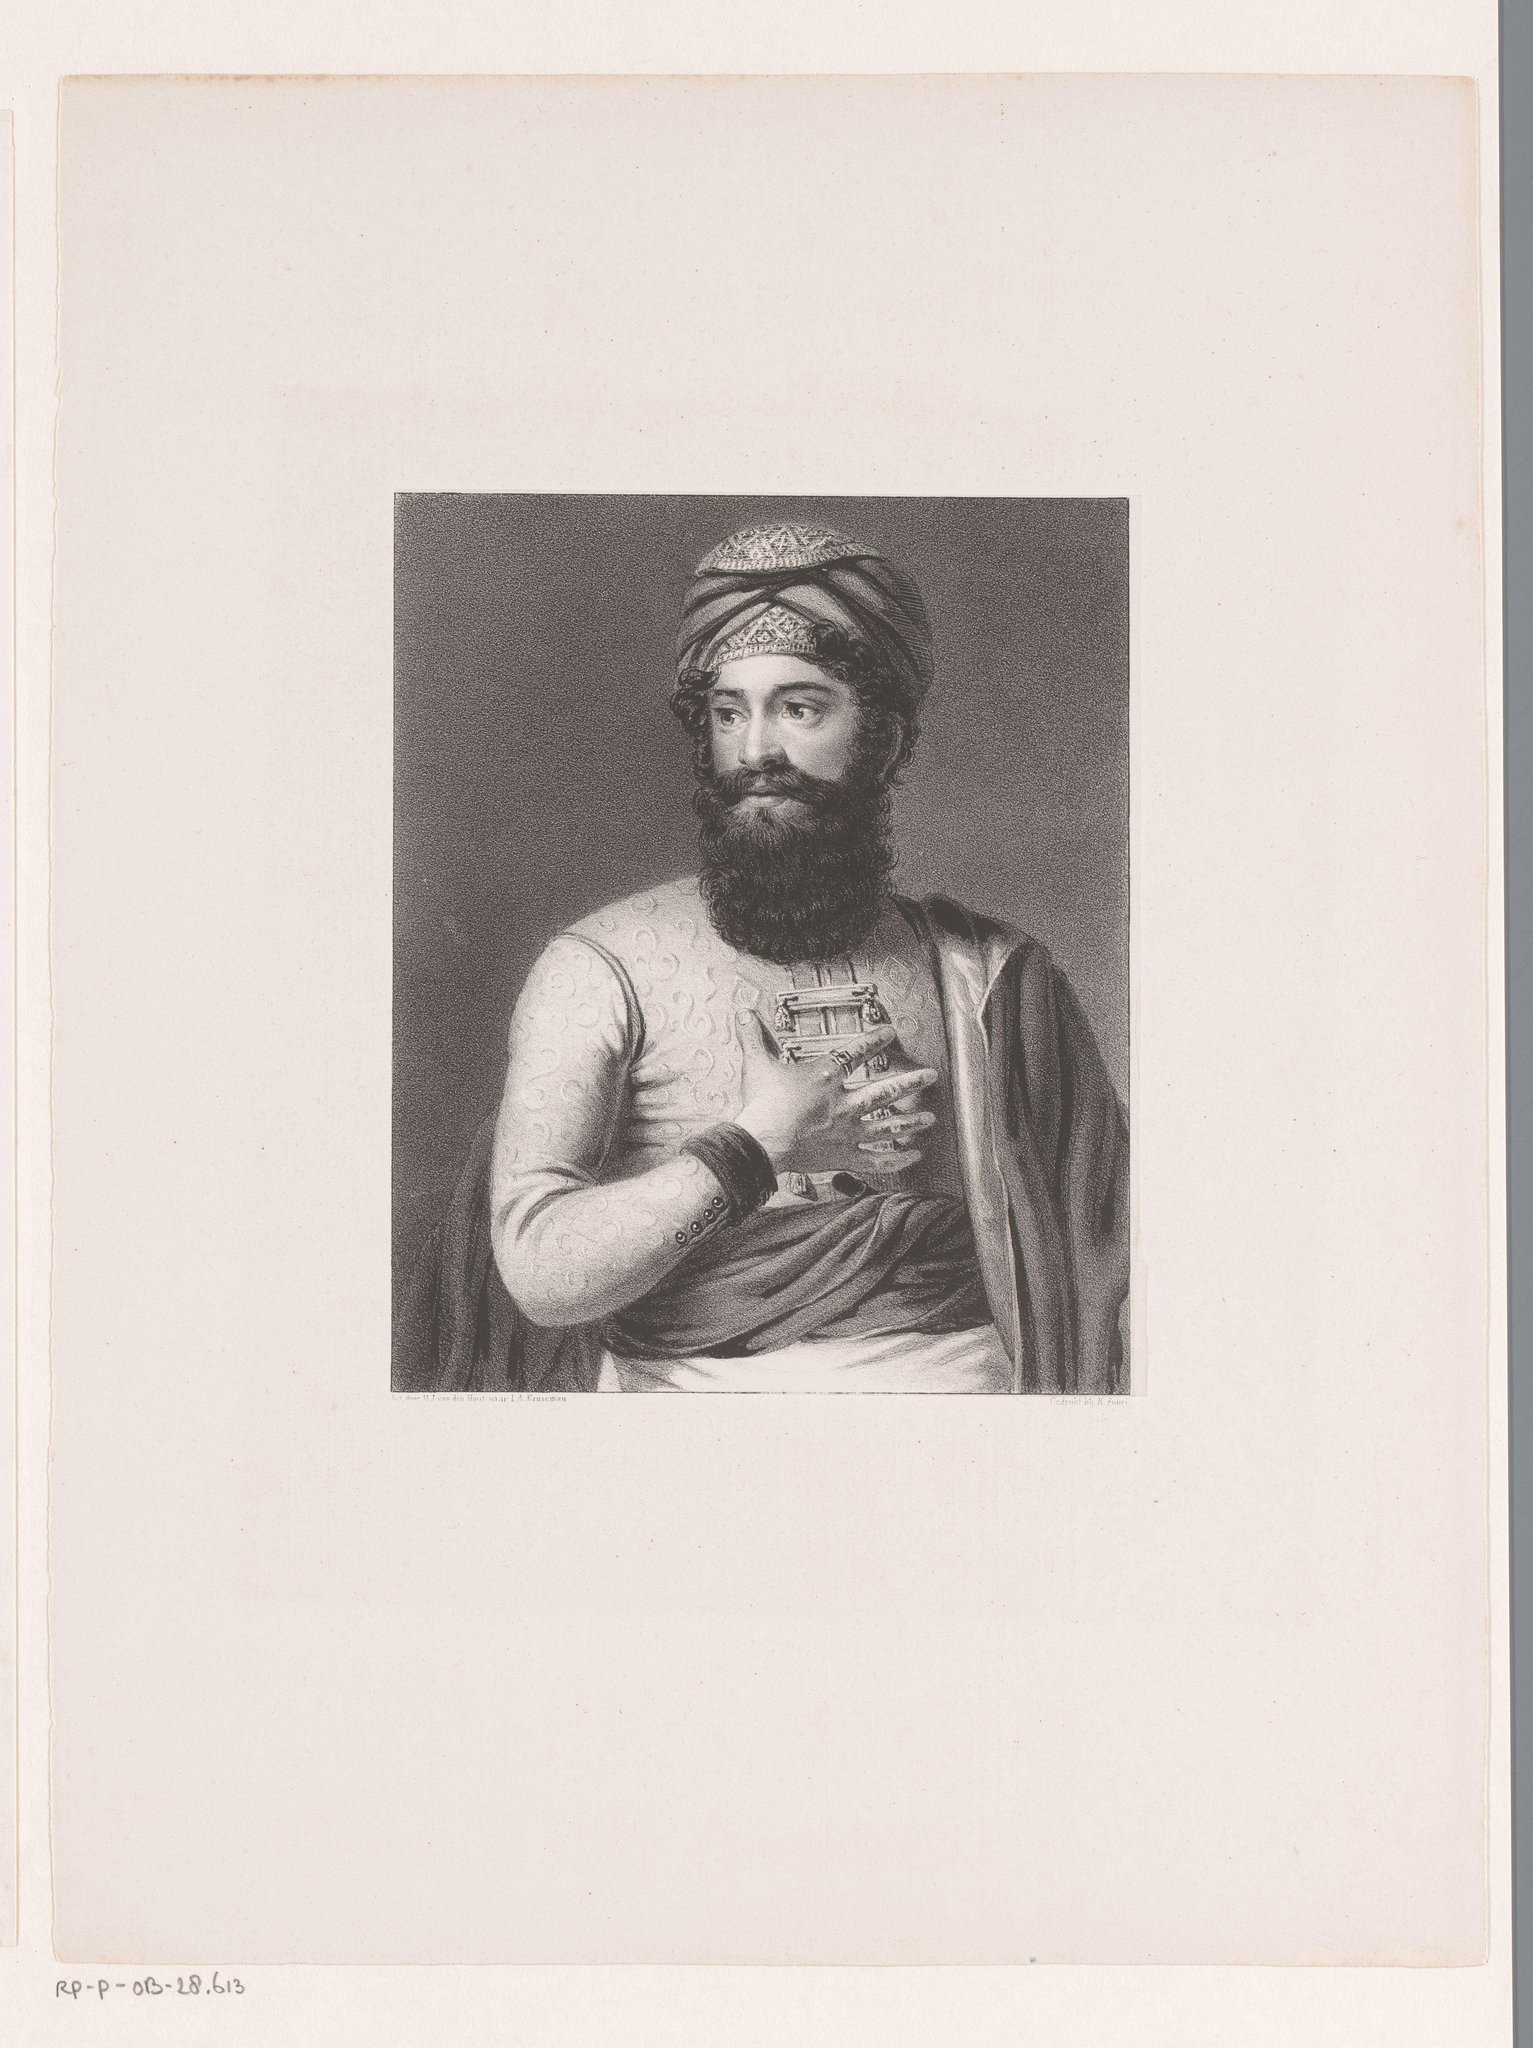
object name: print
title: Portret van een man met tulband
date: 1837-1853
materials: paper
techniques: lithograph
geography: the hague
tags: head-gear: turban, historical persons (+ (full) bust portrait)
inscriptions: collector's mark: Lugt 2228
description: De man heeft een donkere baard, draagt oosterse kleding en een tulband op het hoofd.